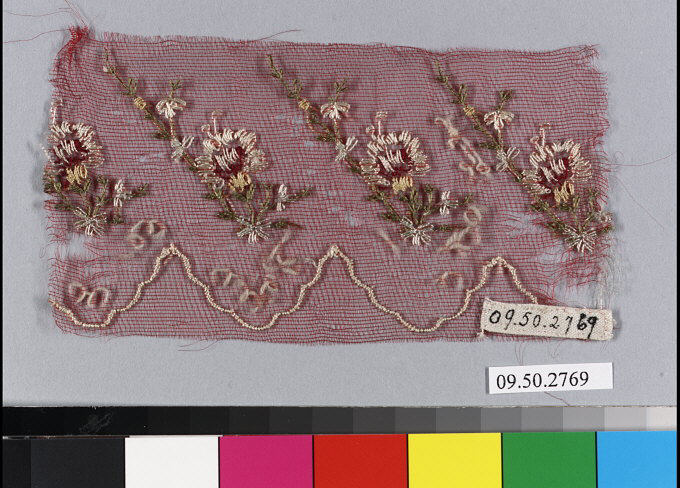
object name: fragment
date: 1801-1900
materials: silk, wool